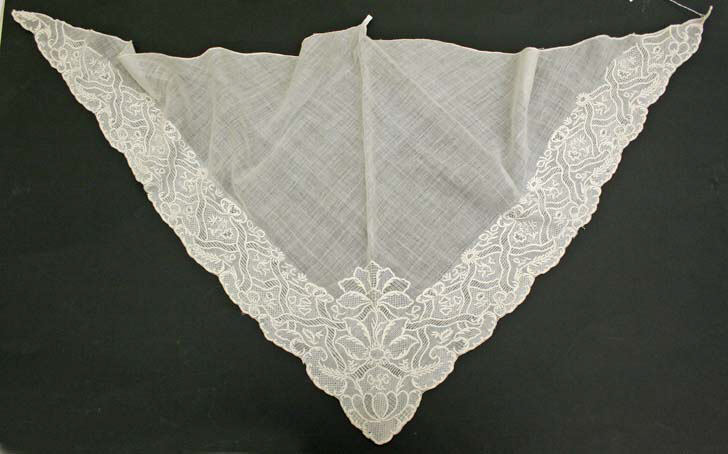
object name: fichu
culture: british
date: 1734-1766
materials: cotton